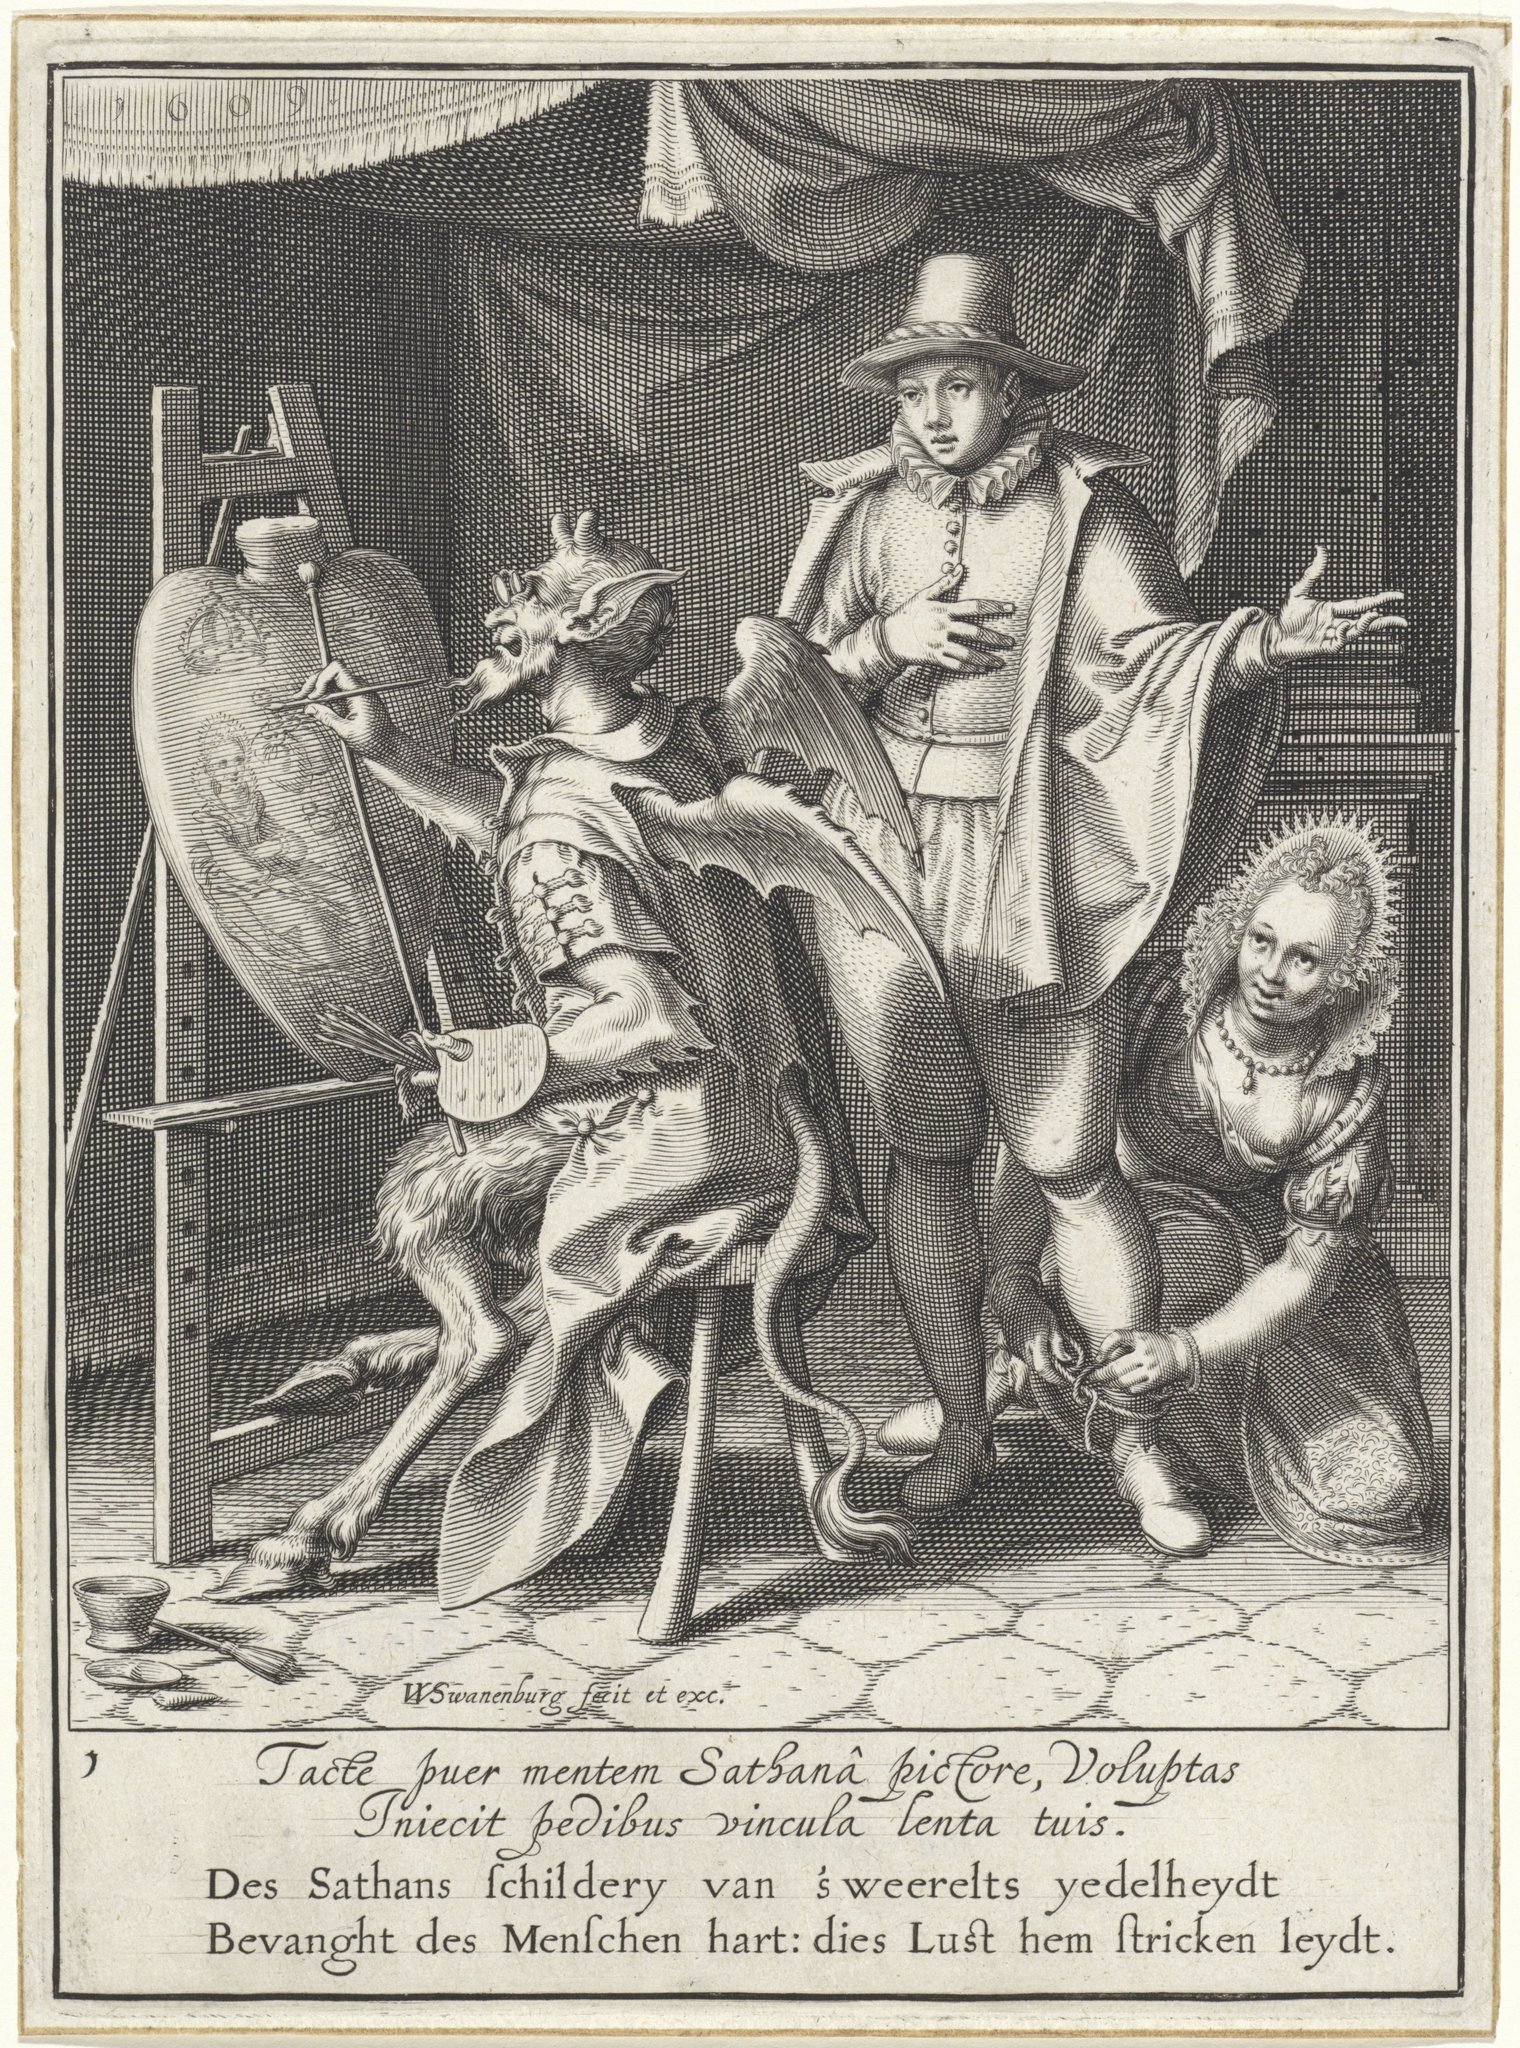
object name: print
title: Allegorieën op het misbruik van aards bezit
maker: willem isaacsz. van swanenburg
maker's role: print maker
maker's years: 1580-1612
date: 1609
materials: paper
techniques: engraving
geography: leiden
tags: adult woman, adult man, devil(s) and demons: satan, heart, painting (including book-illumination, miniature-painting), amorousness, desire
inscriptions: collector's mark: Lugt 2228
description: De duivel zit achter een ezel. Op de ezel staat een menselijk hart, waarop hij symbolen van rijkdom en ijdelheid schildert. Bij hem staat een jonge man. Een vrouw knielt naast hem en knoopt een touw om zijn enkel. Onder de voorstelling bevindt zich een tweeregelige, Latijnse tekst en een tweeregelig, Nederlands gedicht waarin de voorstelling en de betekenis ervan wordt toegelicht.